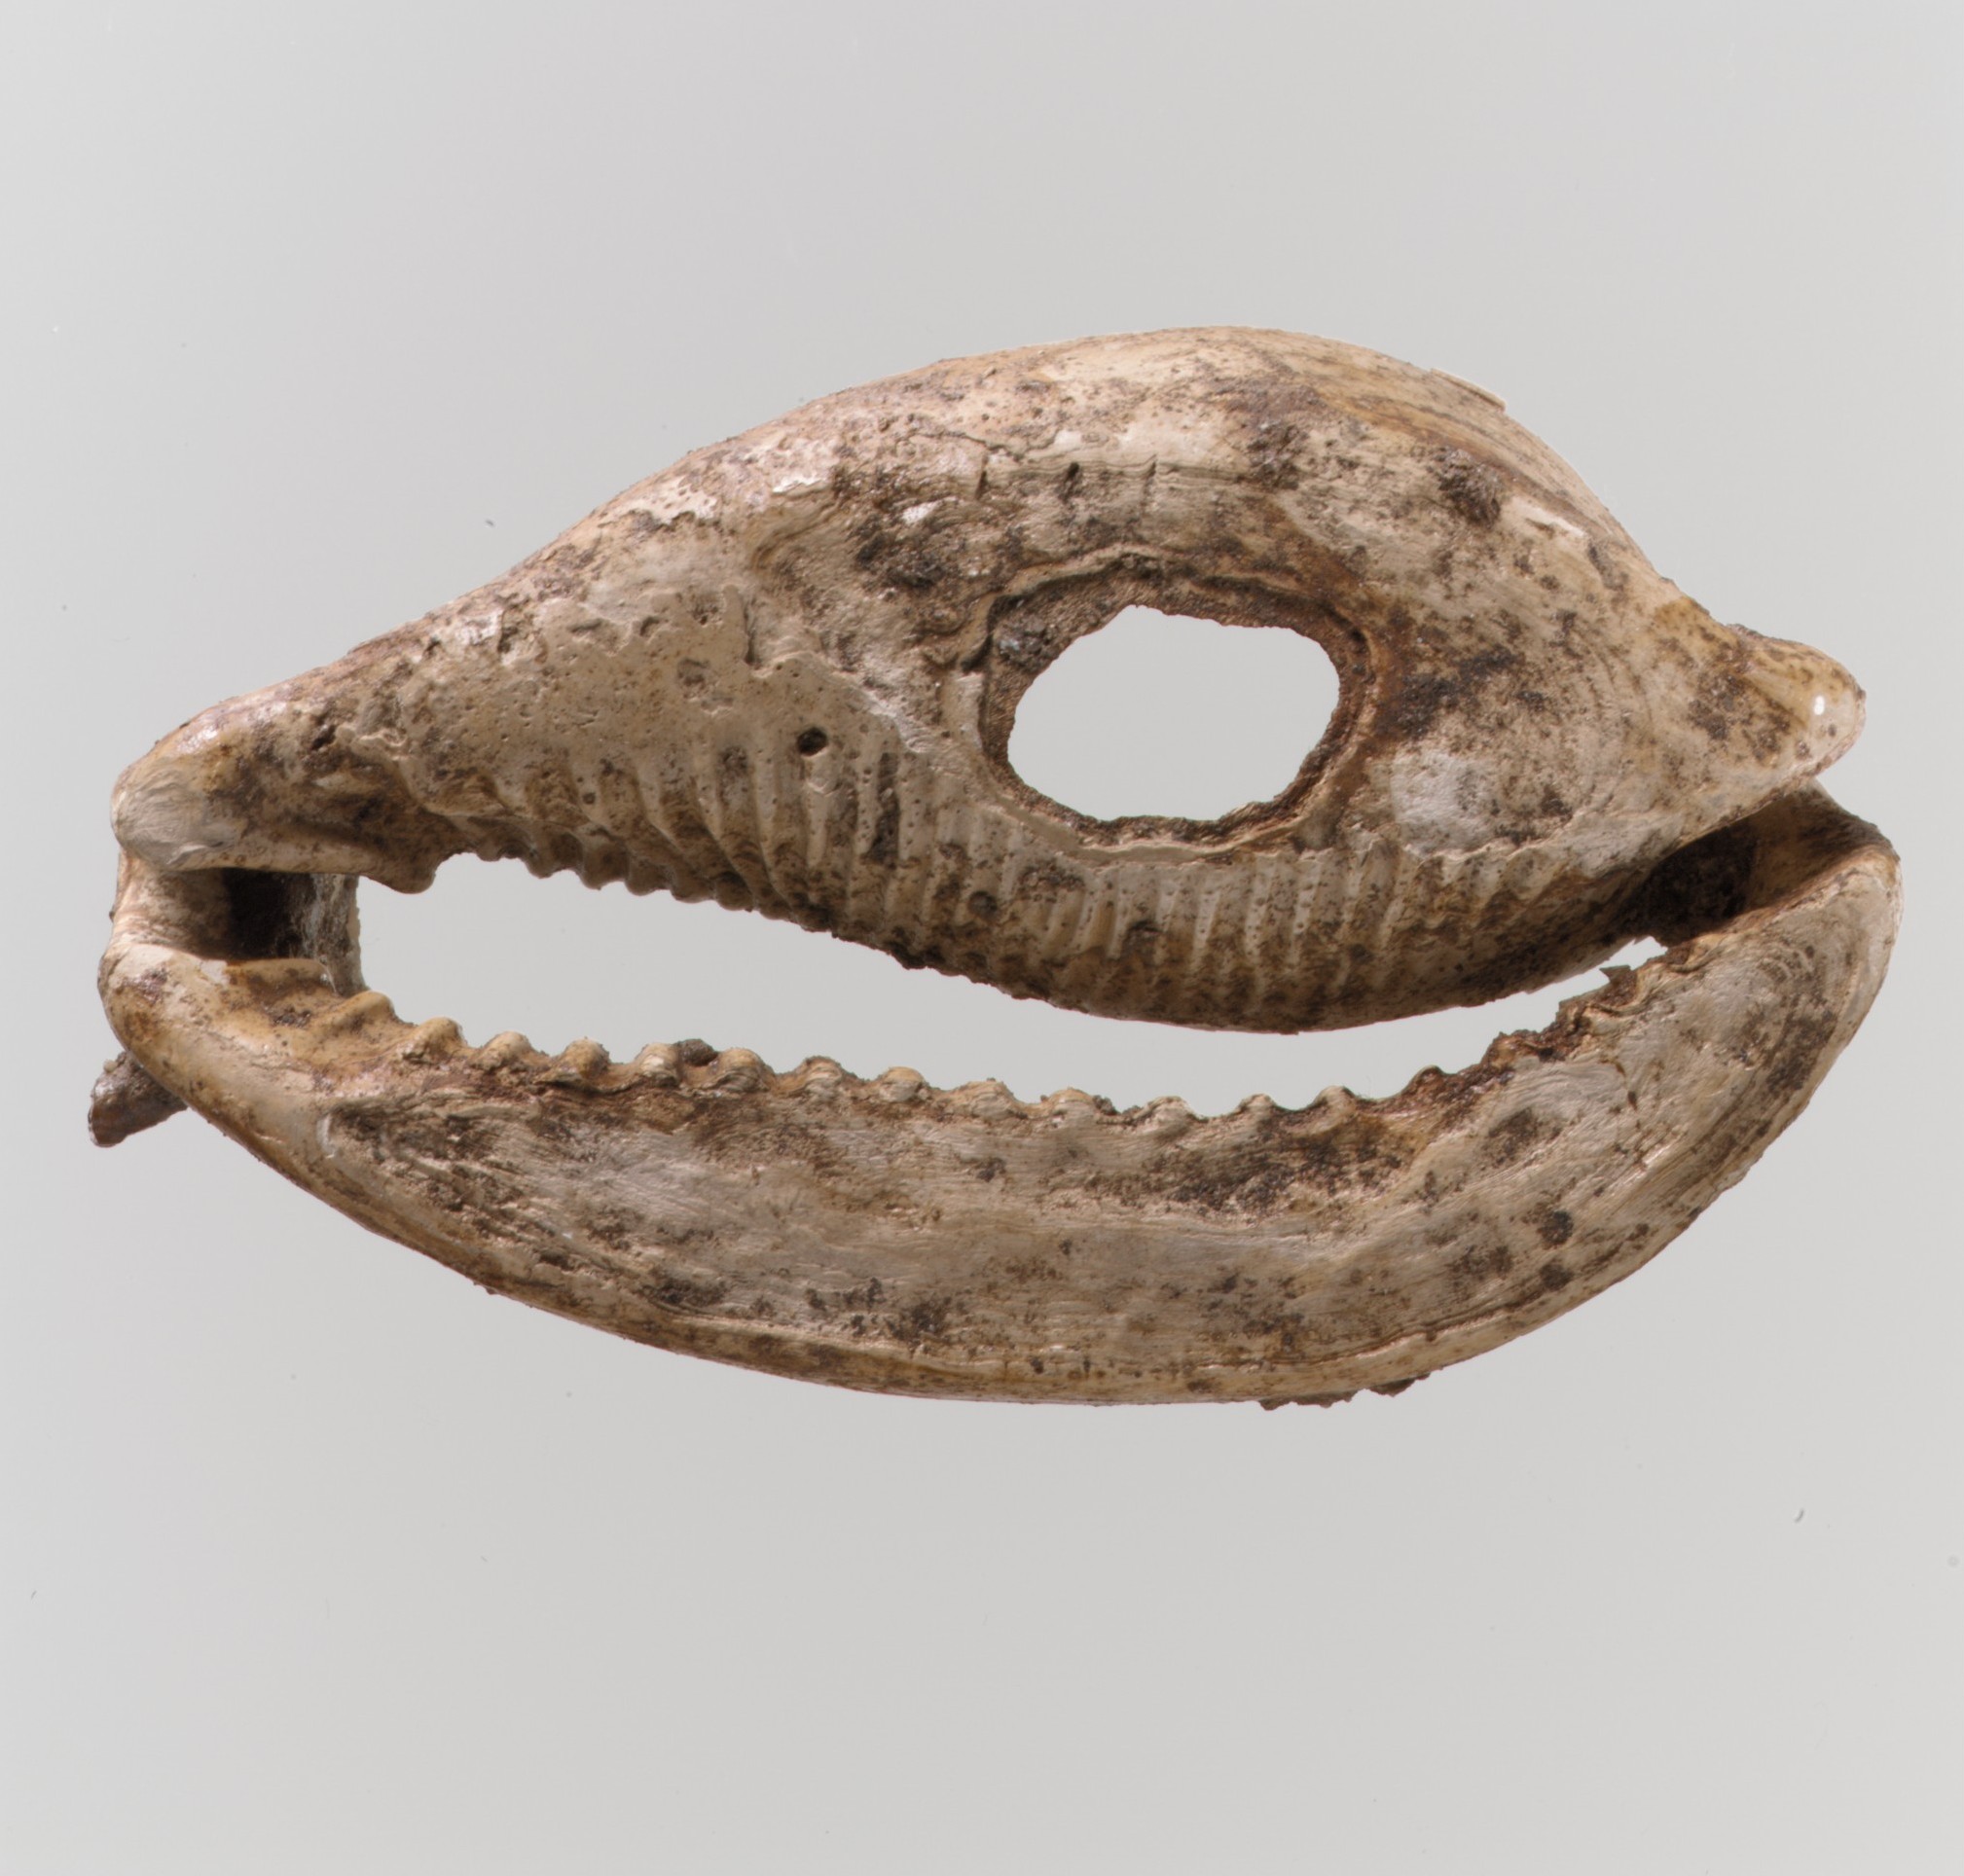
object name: shell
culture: frankish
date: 501-700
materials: shell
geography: germany